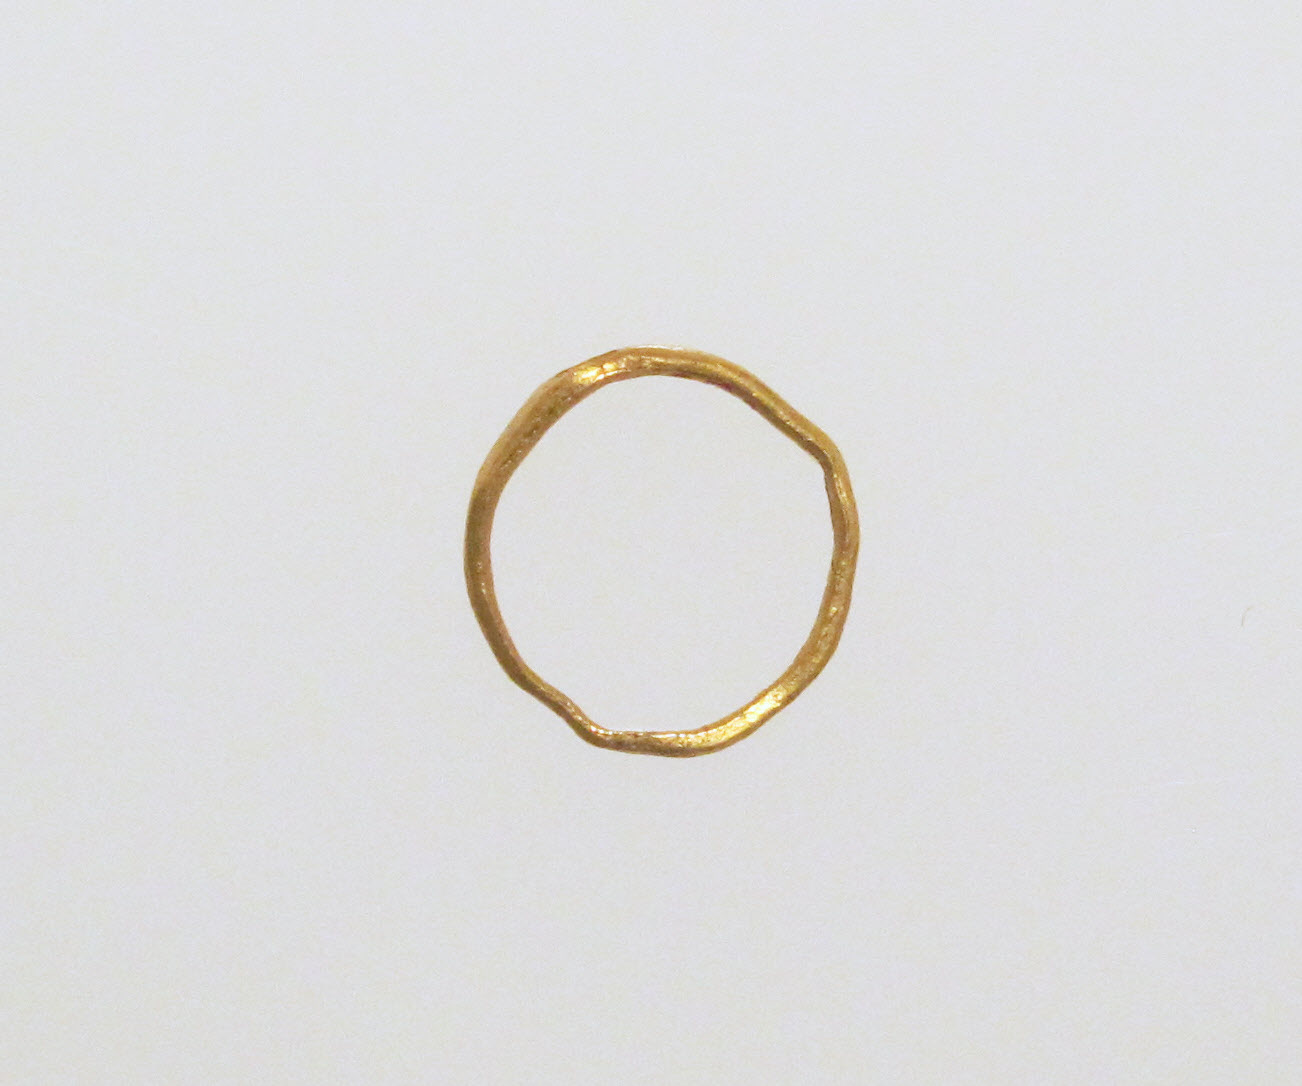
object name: ring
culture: roman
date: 670 BCE-330 CE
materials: gold